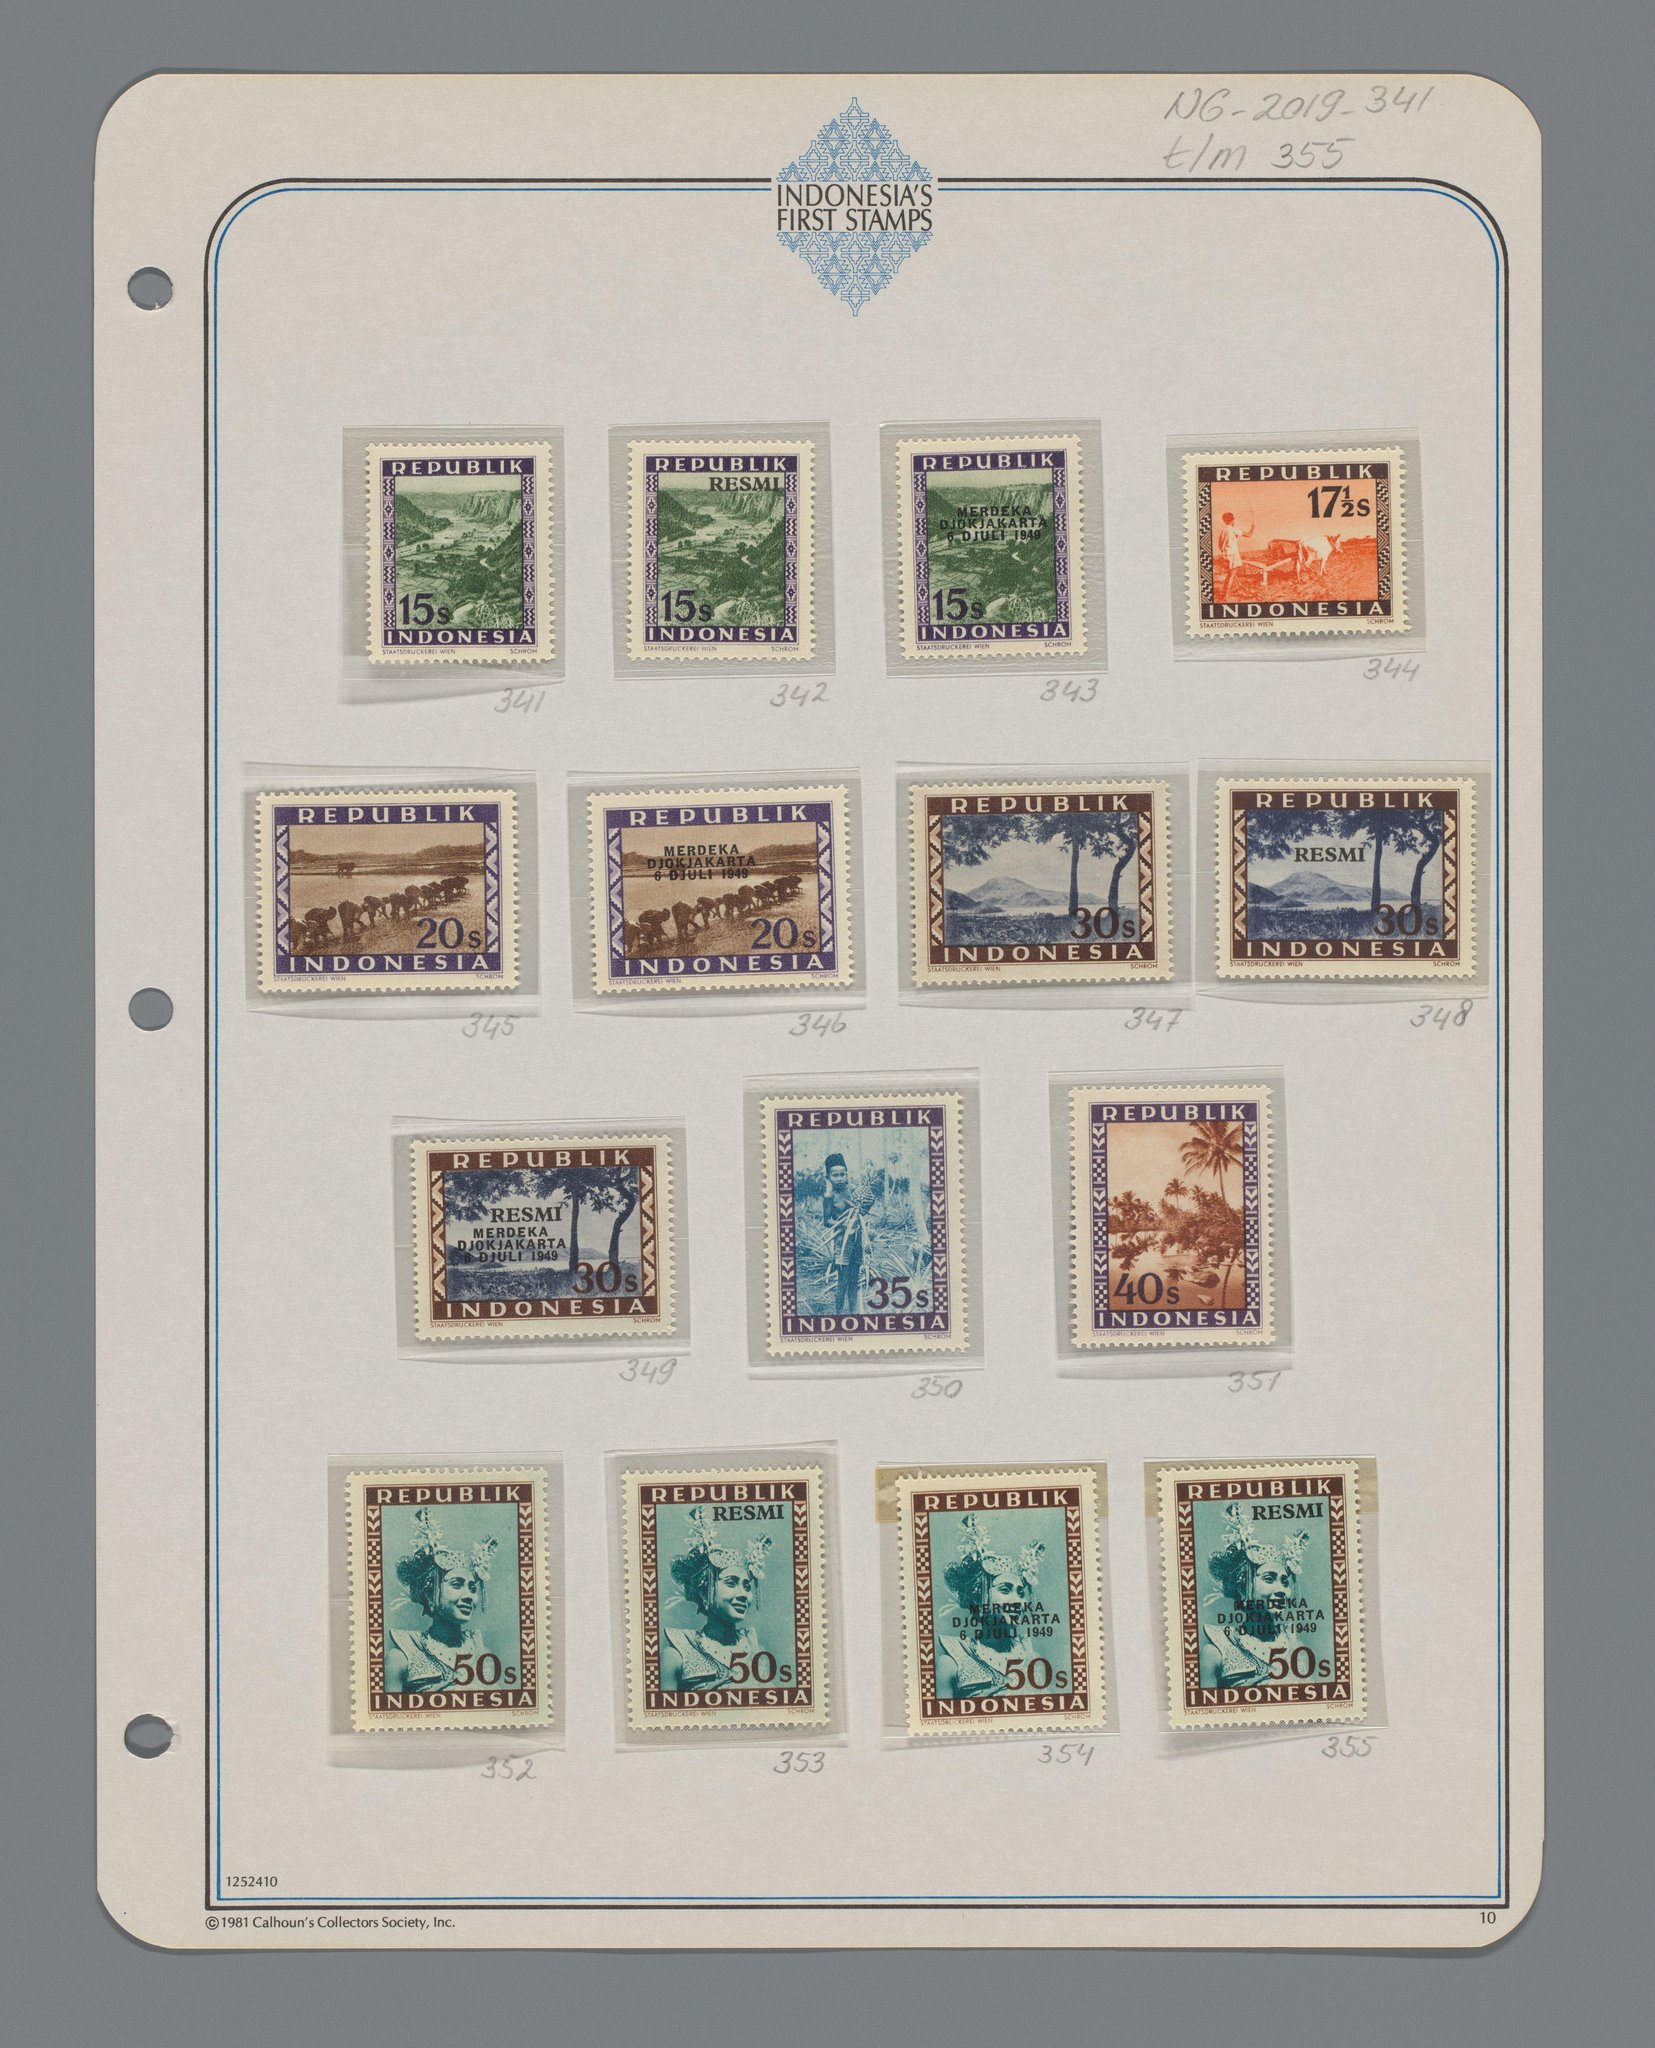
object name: postage stamp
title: Postzegel Republik Indonesia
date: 1949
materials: paper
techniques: photoaquatint, engraving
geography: vienna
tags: indonesia